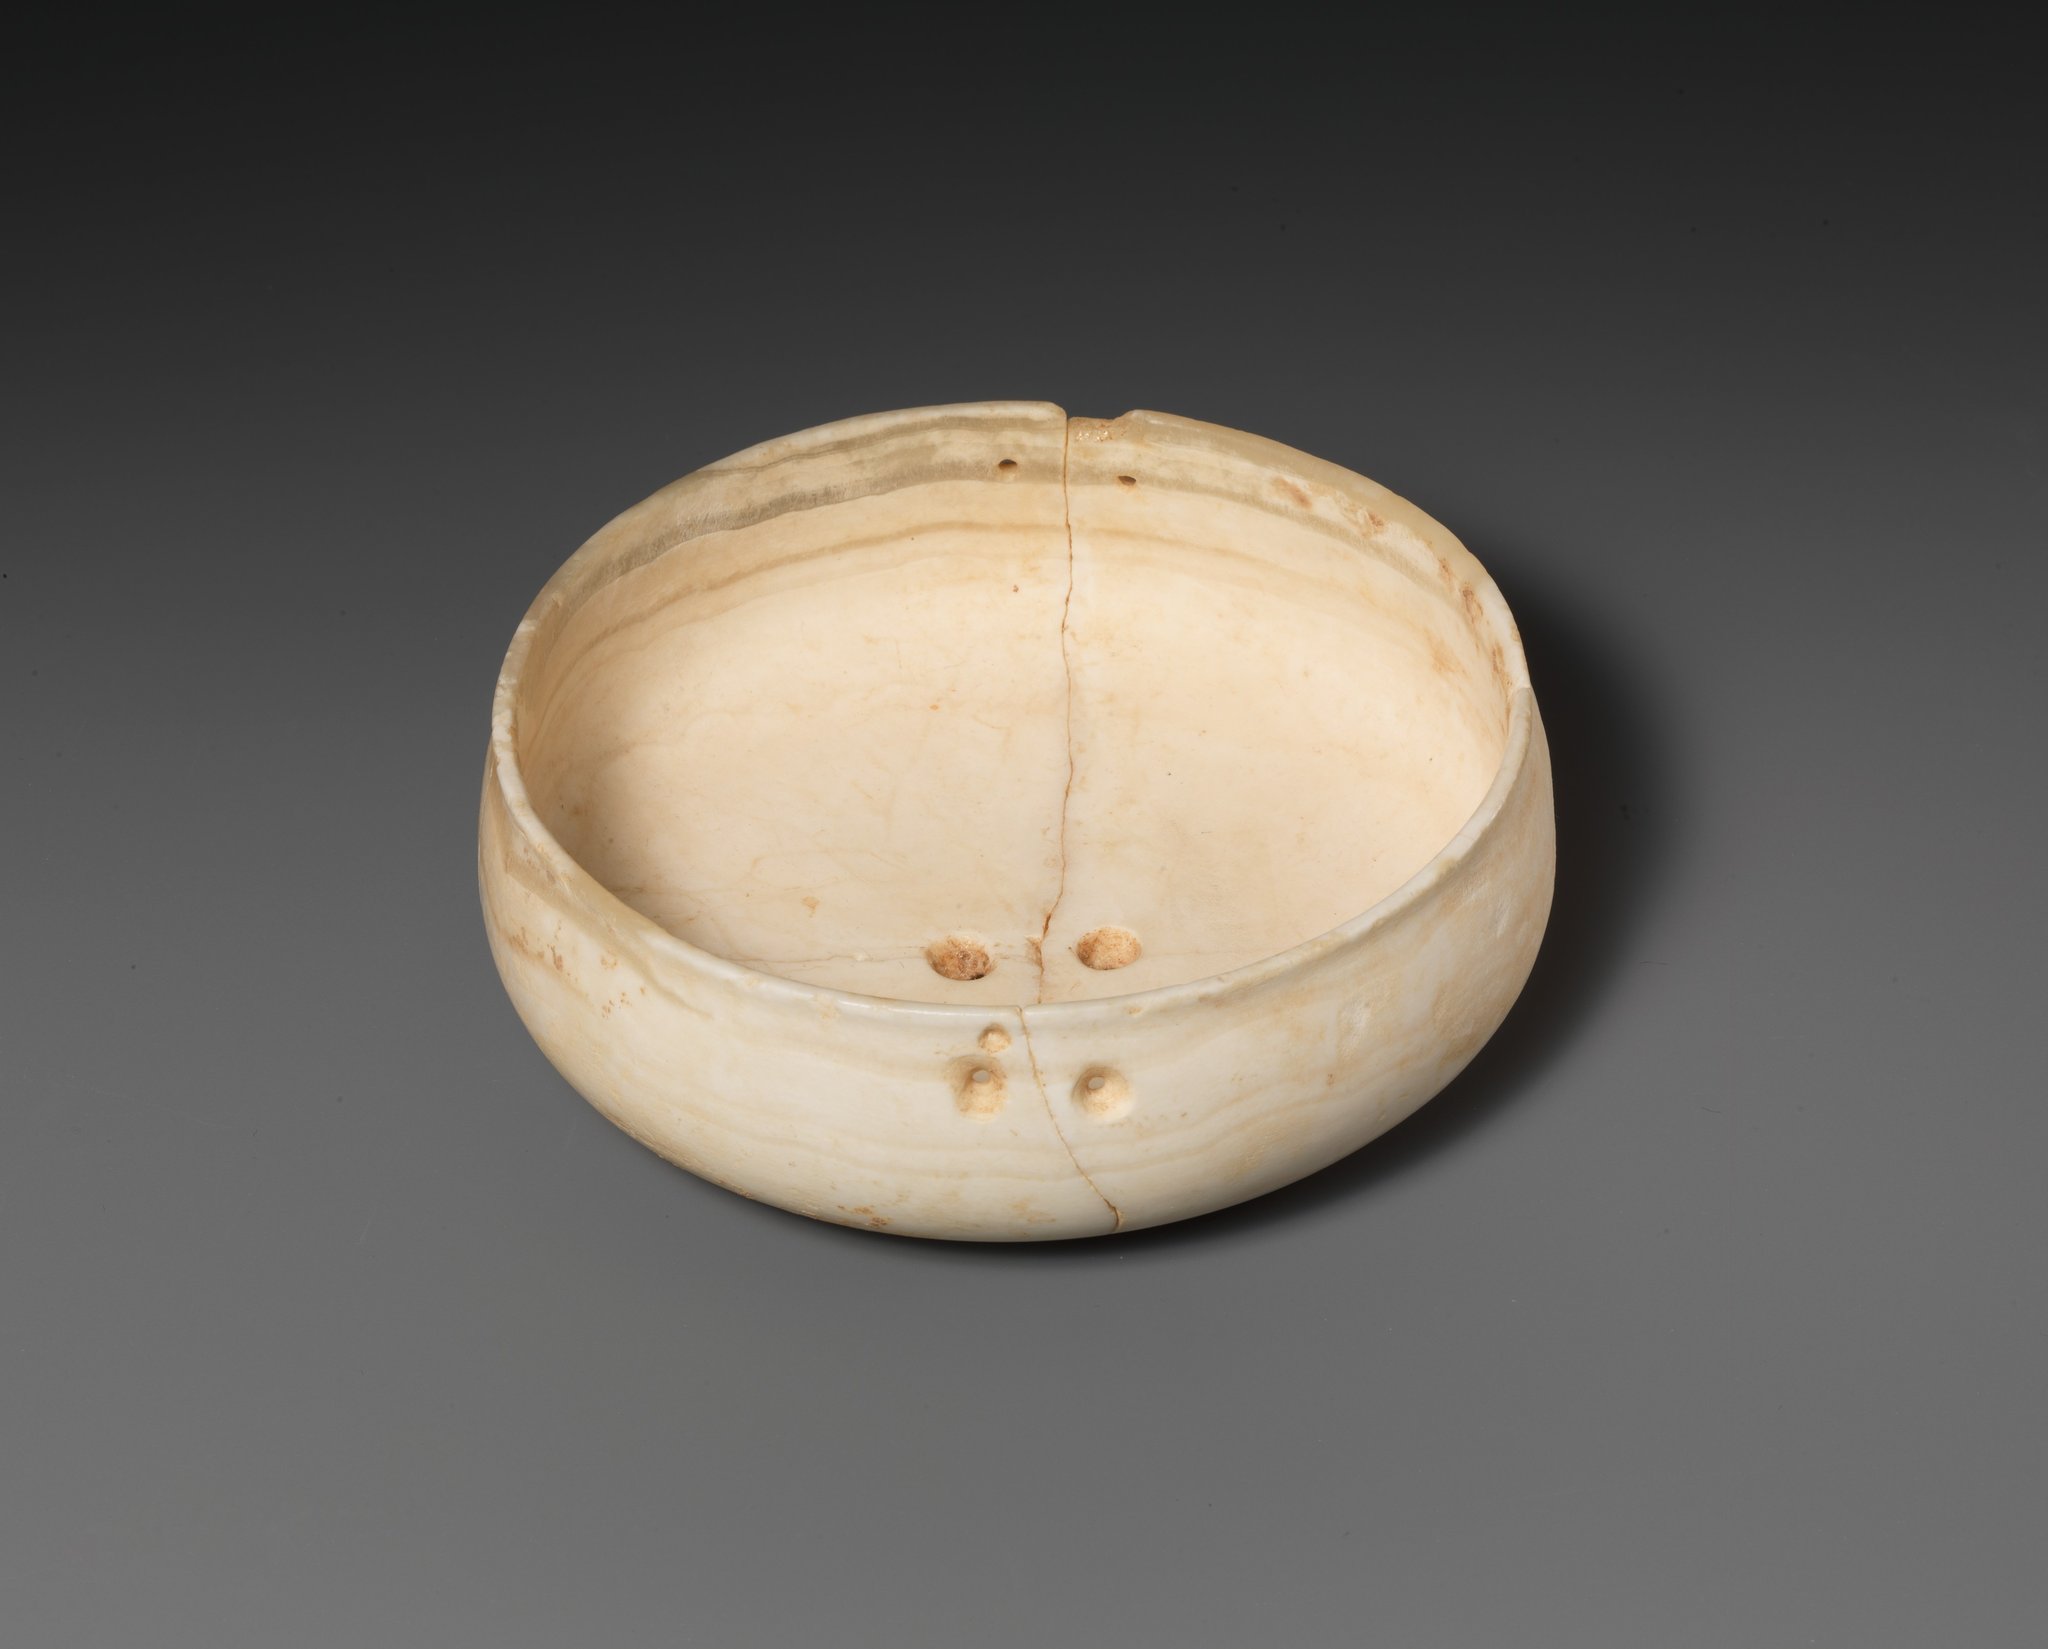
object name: bowl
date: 7333-7001 BCE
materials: alabaster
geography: syria